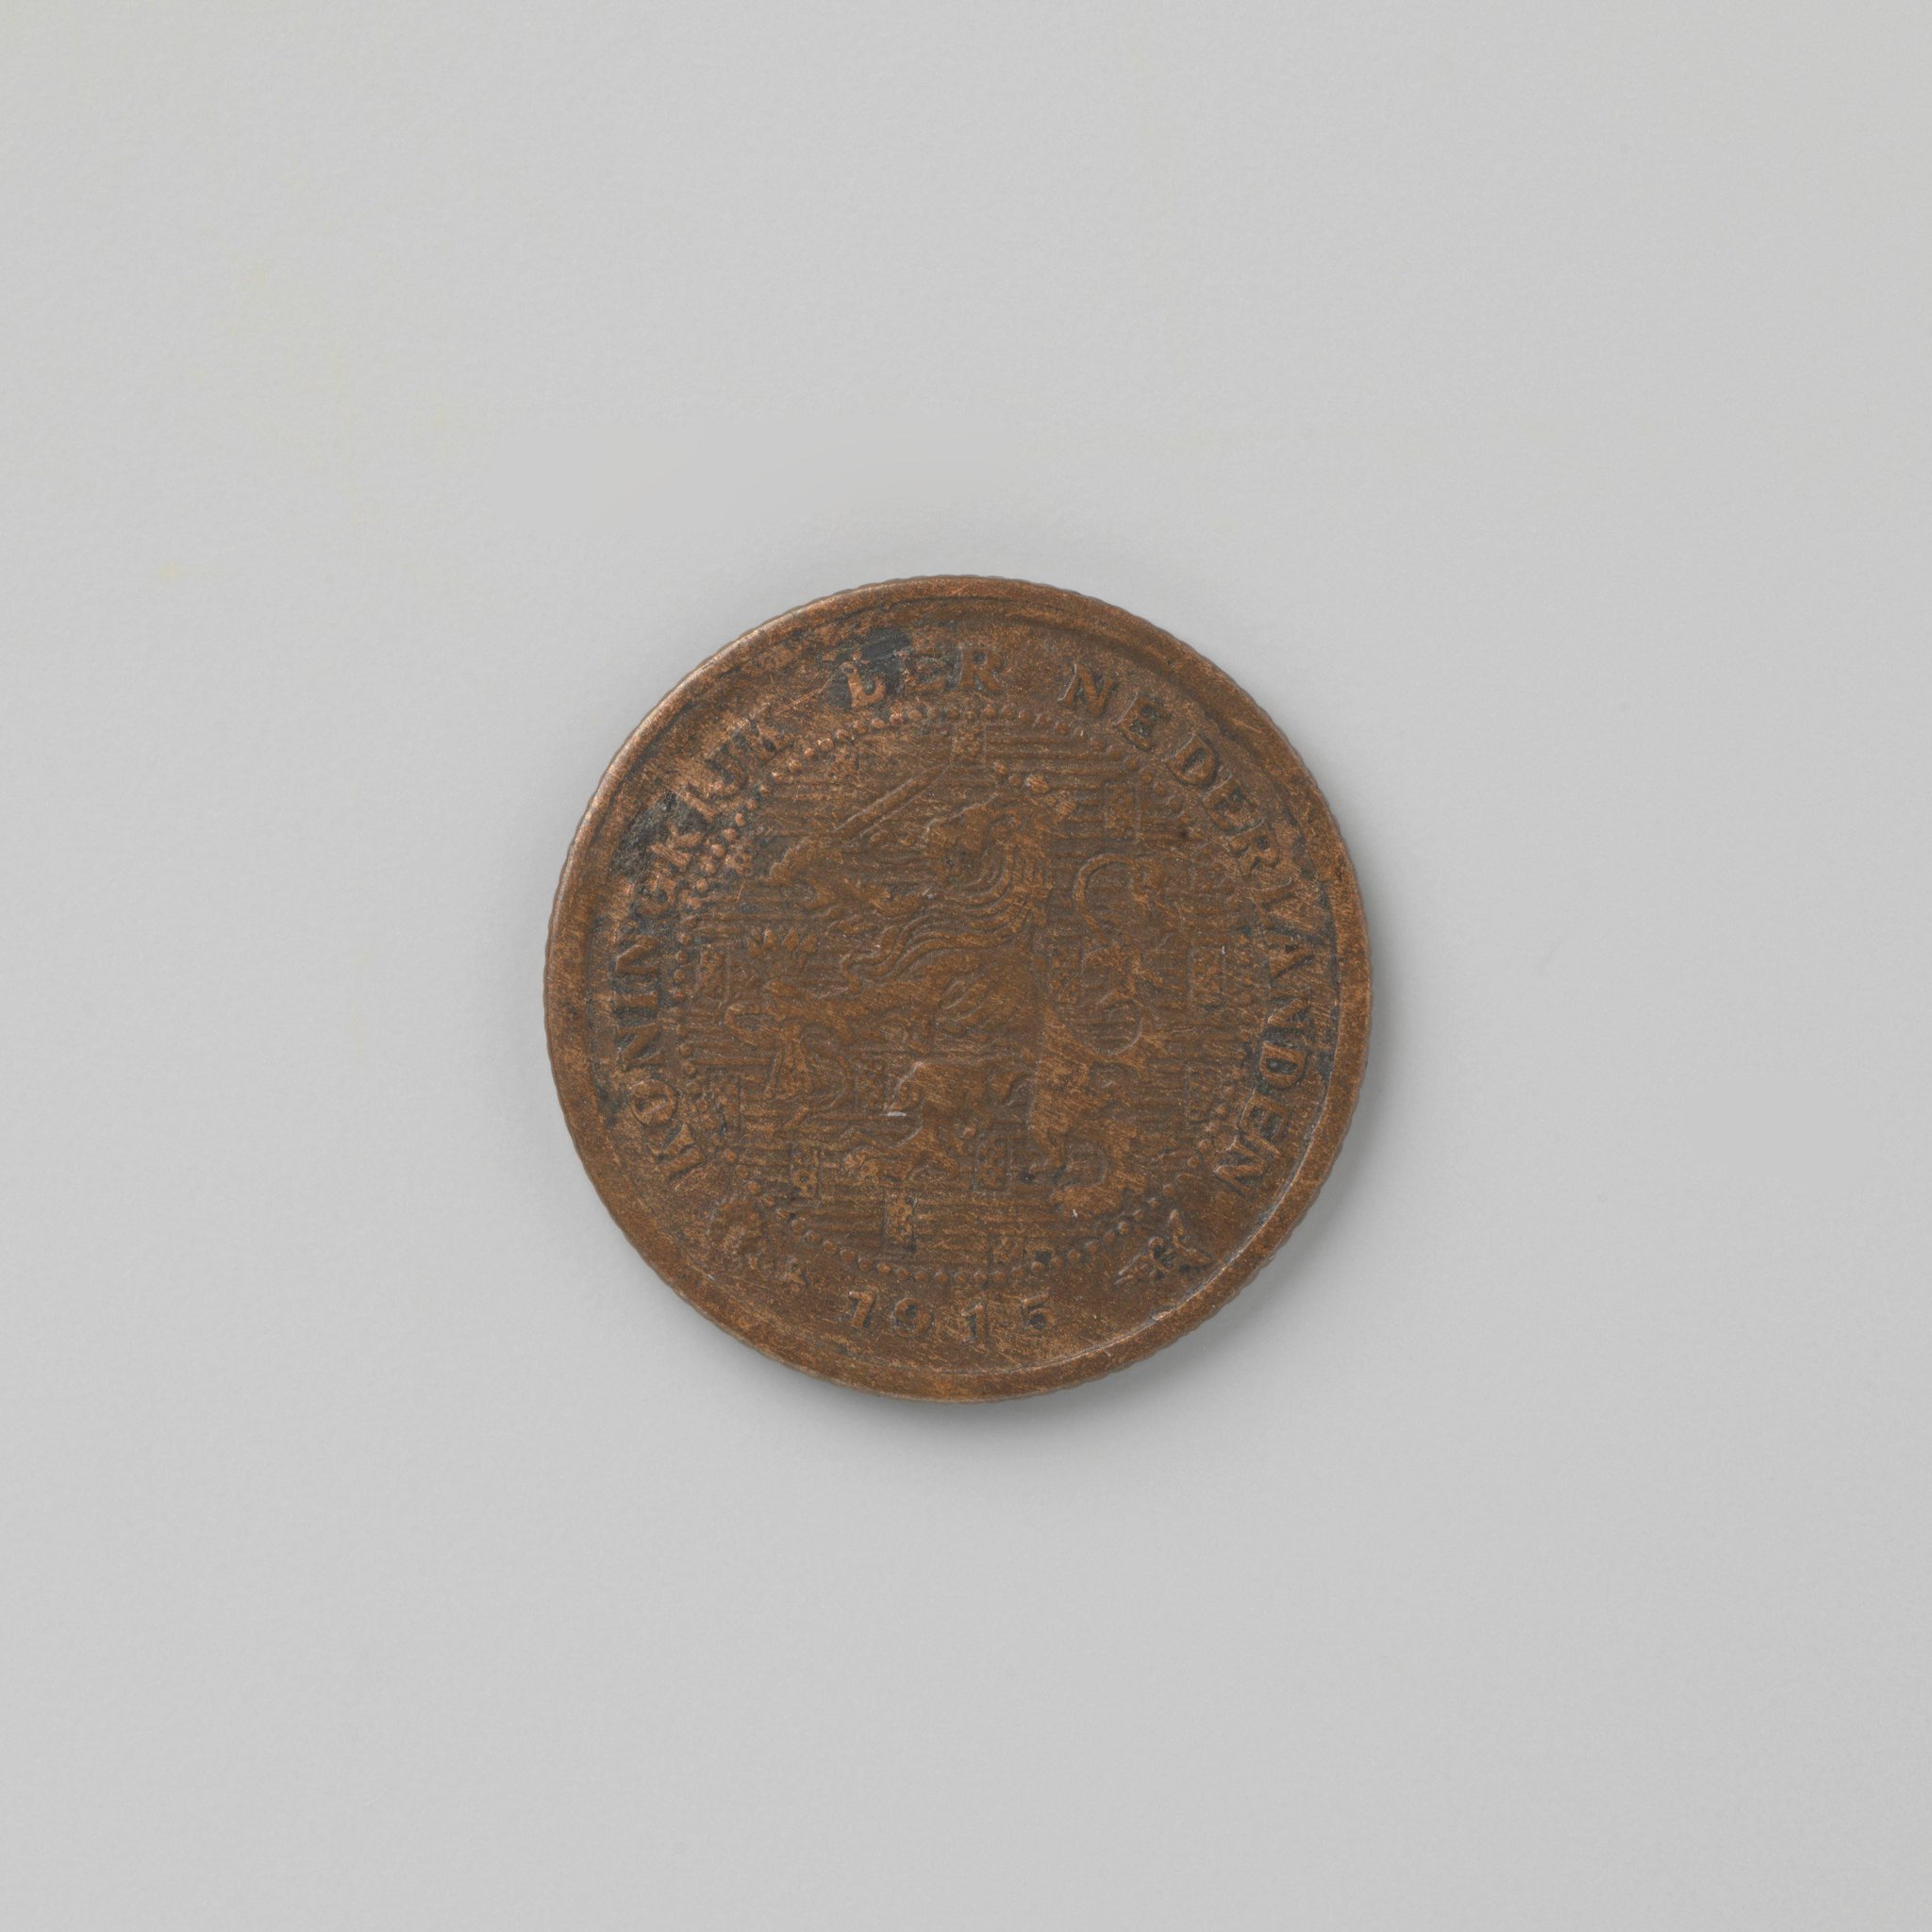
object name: coin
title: Nederland, ½ cent,1915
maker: wilhelmina of the netherlands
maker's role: print maker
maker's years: 1880-1962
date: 1915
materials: bronze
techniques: striking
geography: utrecht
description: Bronzen munt. Voorzijde: in een veld rijkswapen. Jaartal onderaan in omschrift. Keerzijde: binnen twee samengebonden oranjetakken waarde-aanduiding ½ cent. Kartelrand.